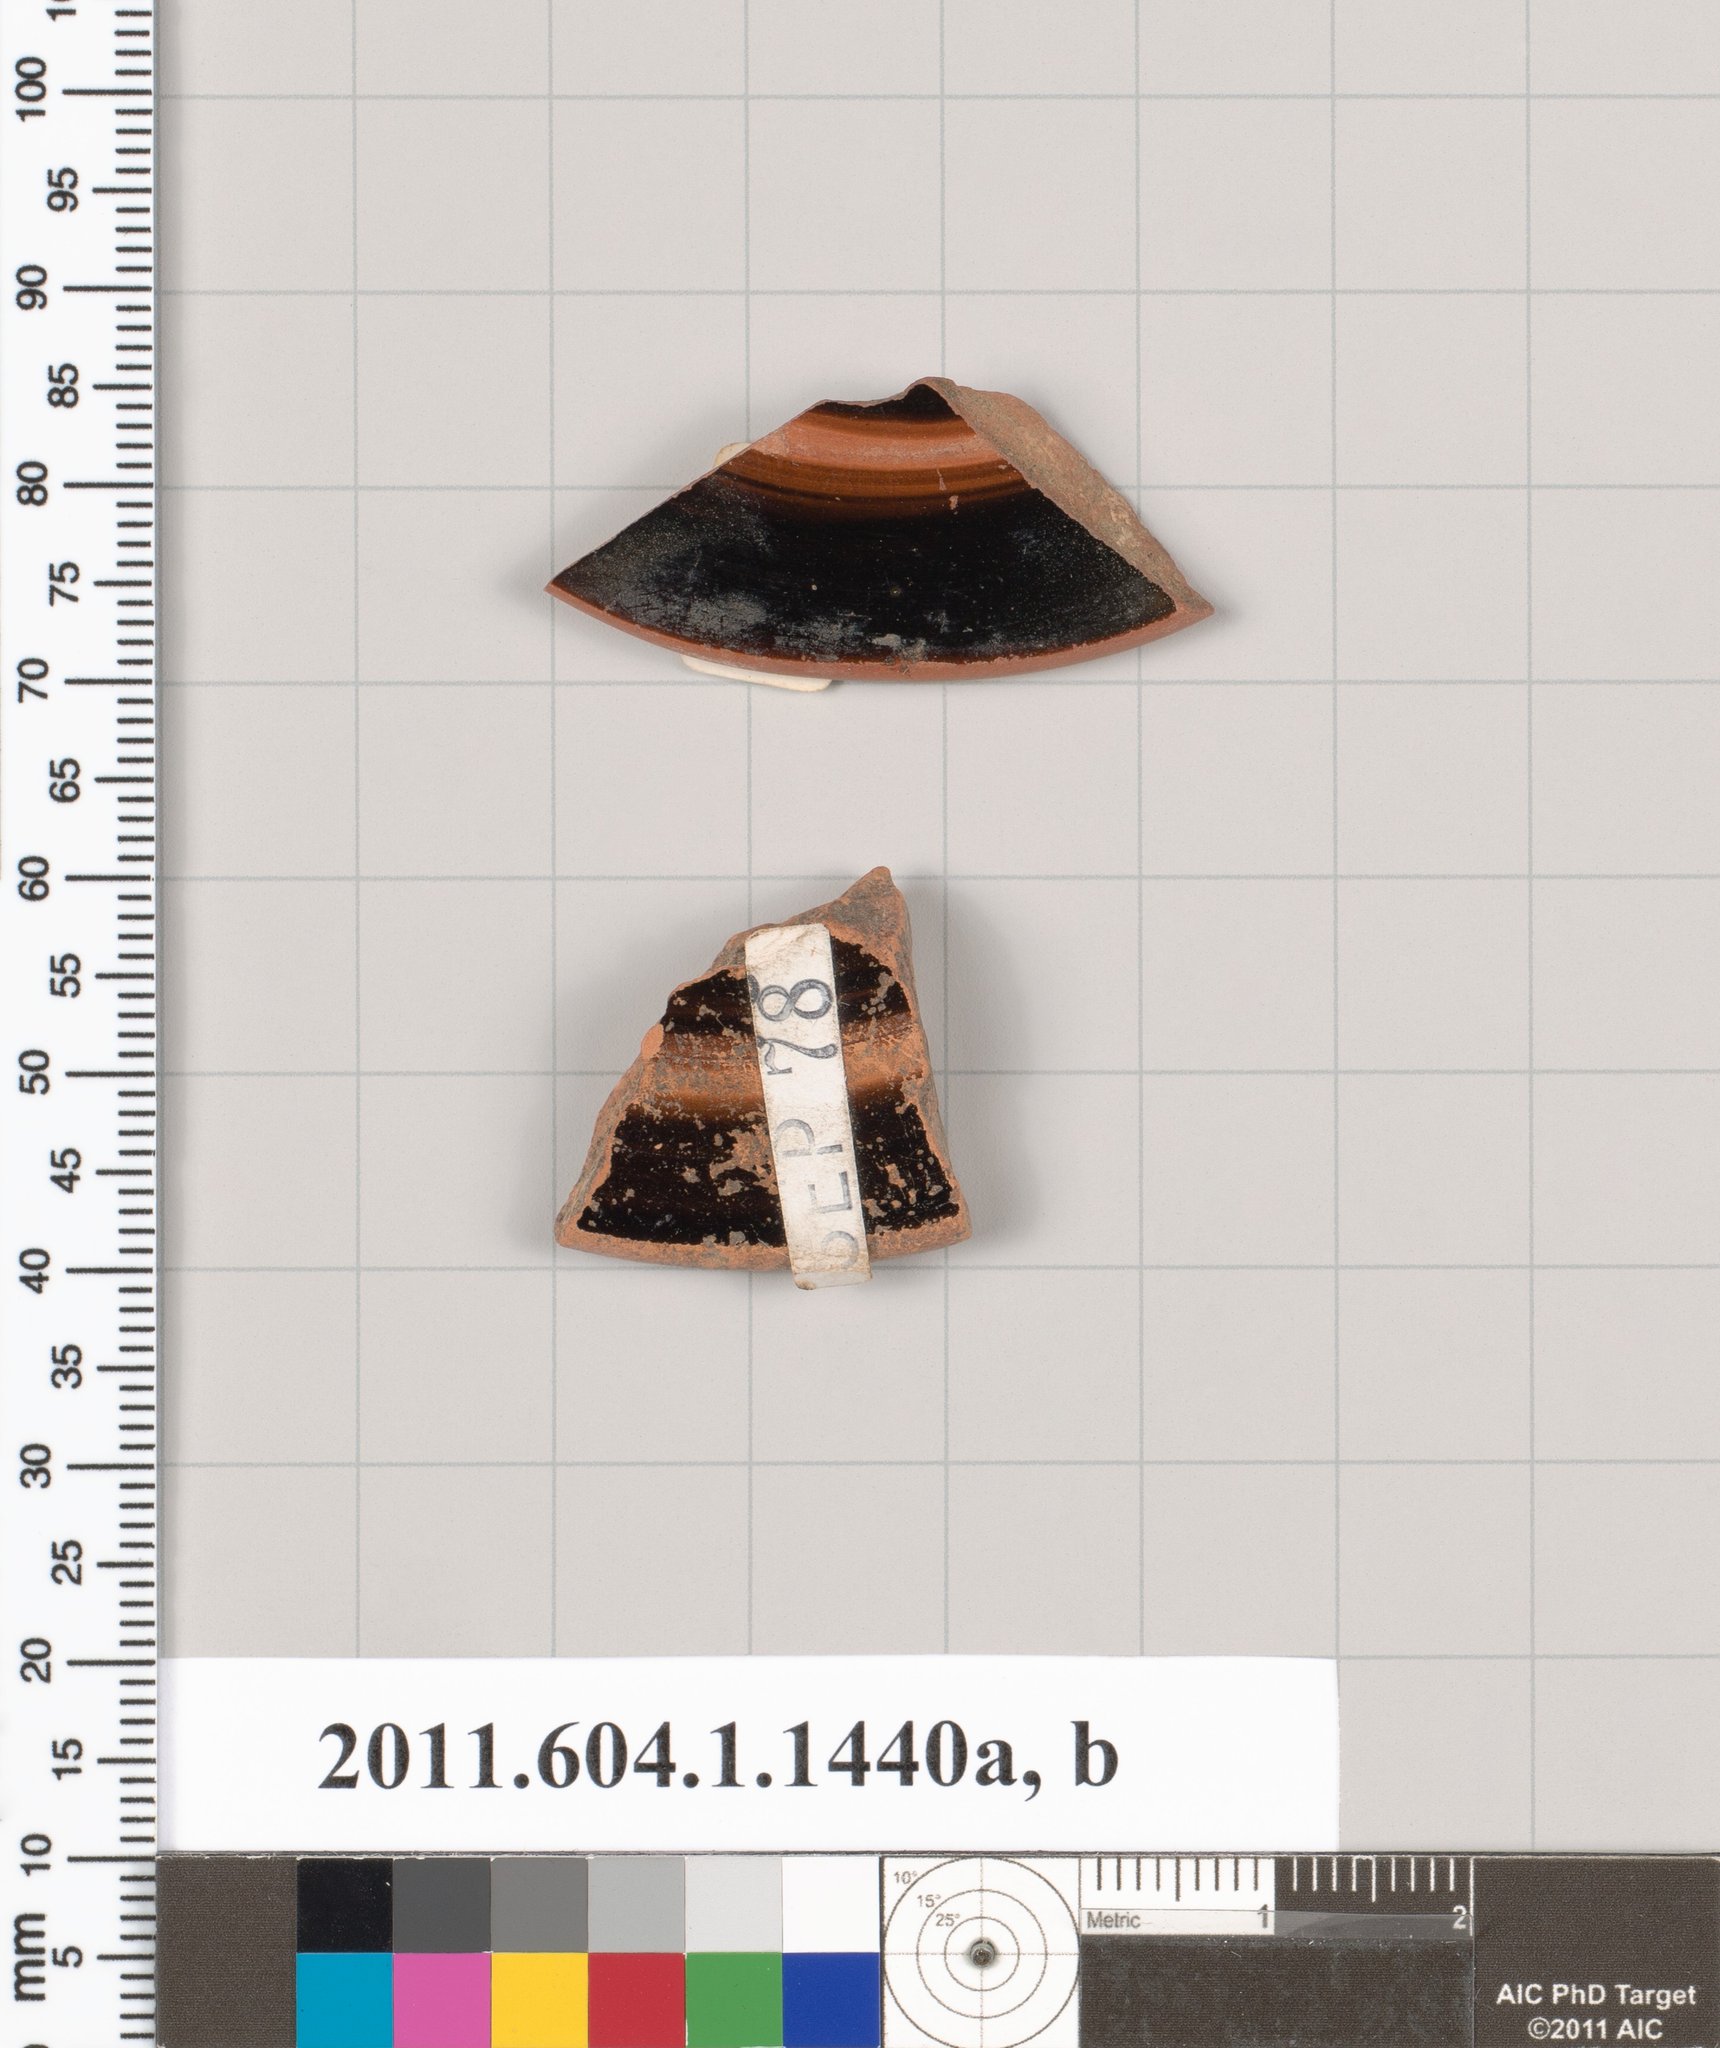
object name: kylix fragment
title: Terracotta fragments of kylikes (drinking cups)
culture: greek, attic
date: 500-401 BCE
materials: terracotta